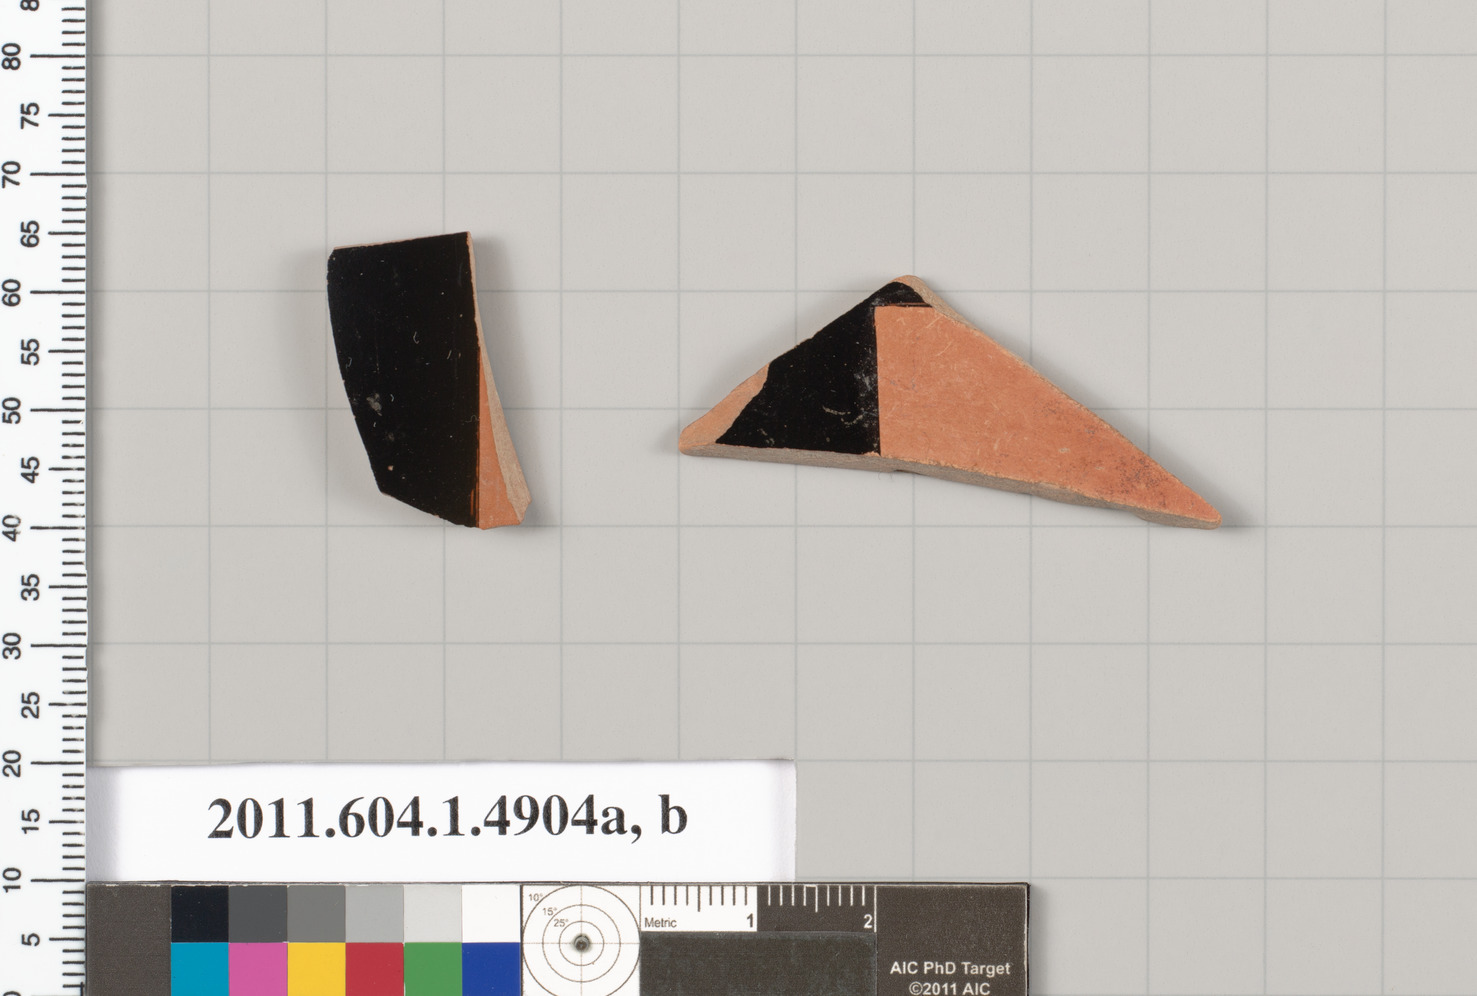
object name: kylix fragment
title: Terracotta fragments of kylikes (drinking cups)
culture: greek, attic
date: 600-401 BCE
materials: terracotta